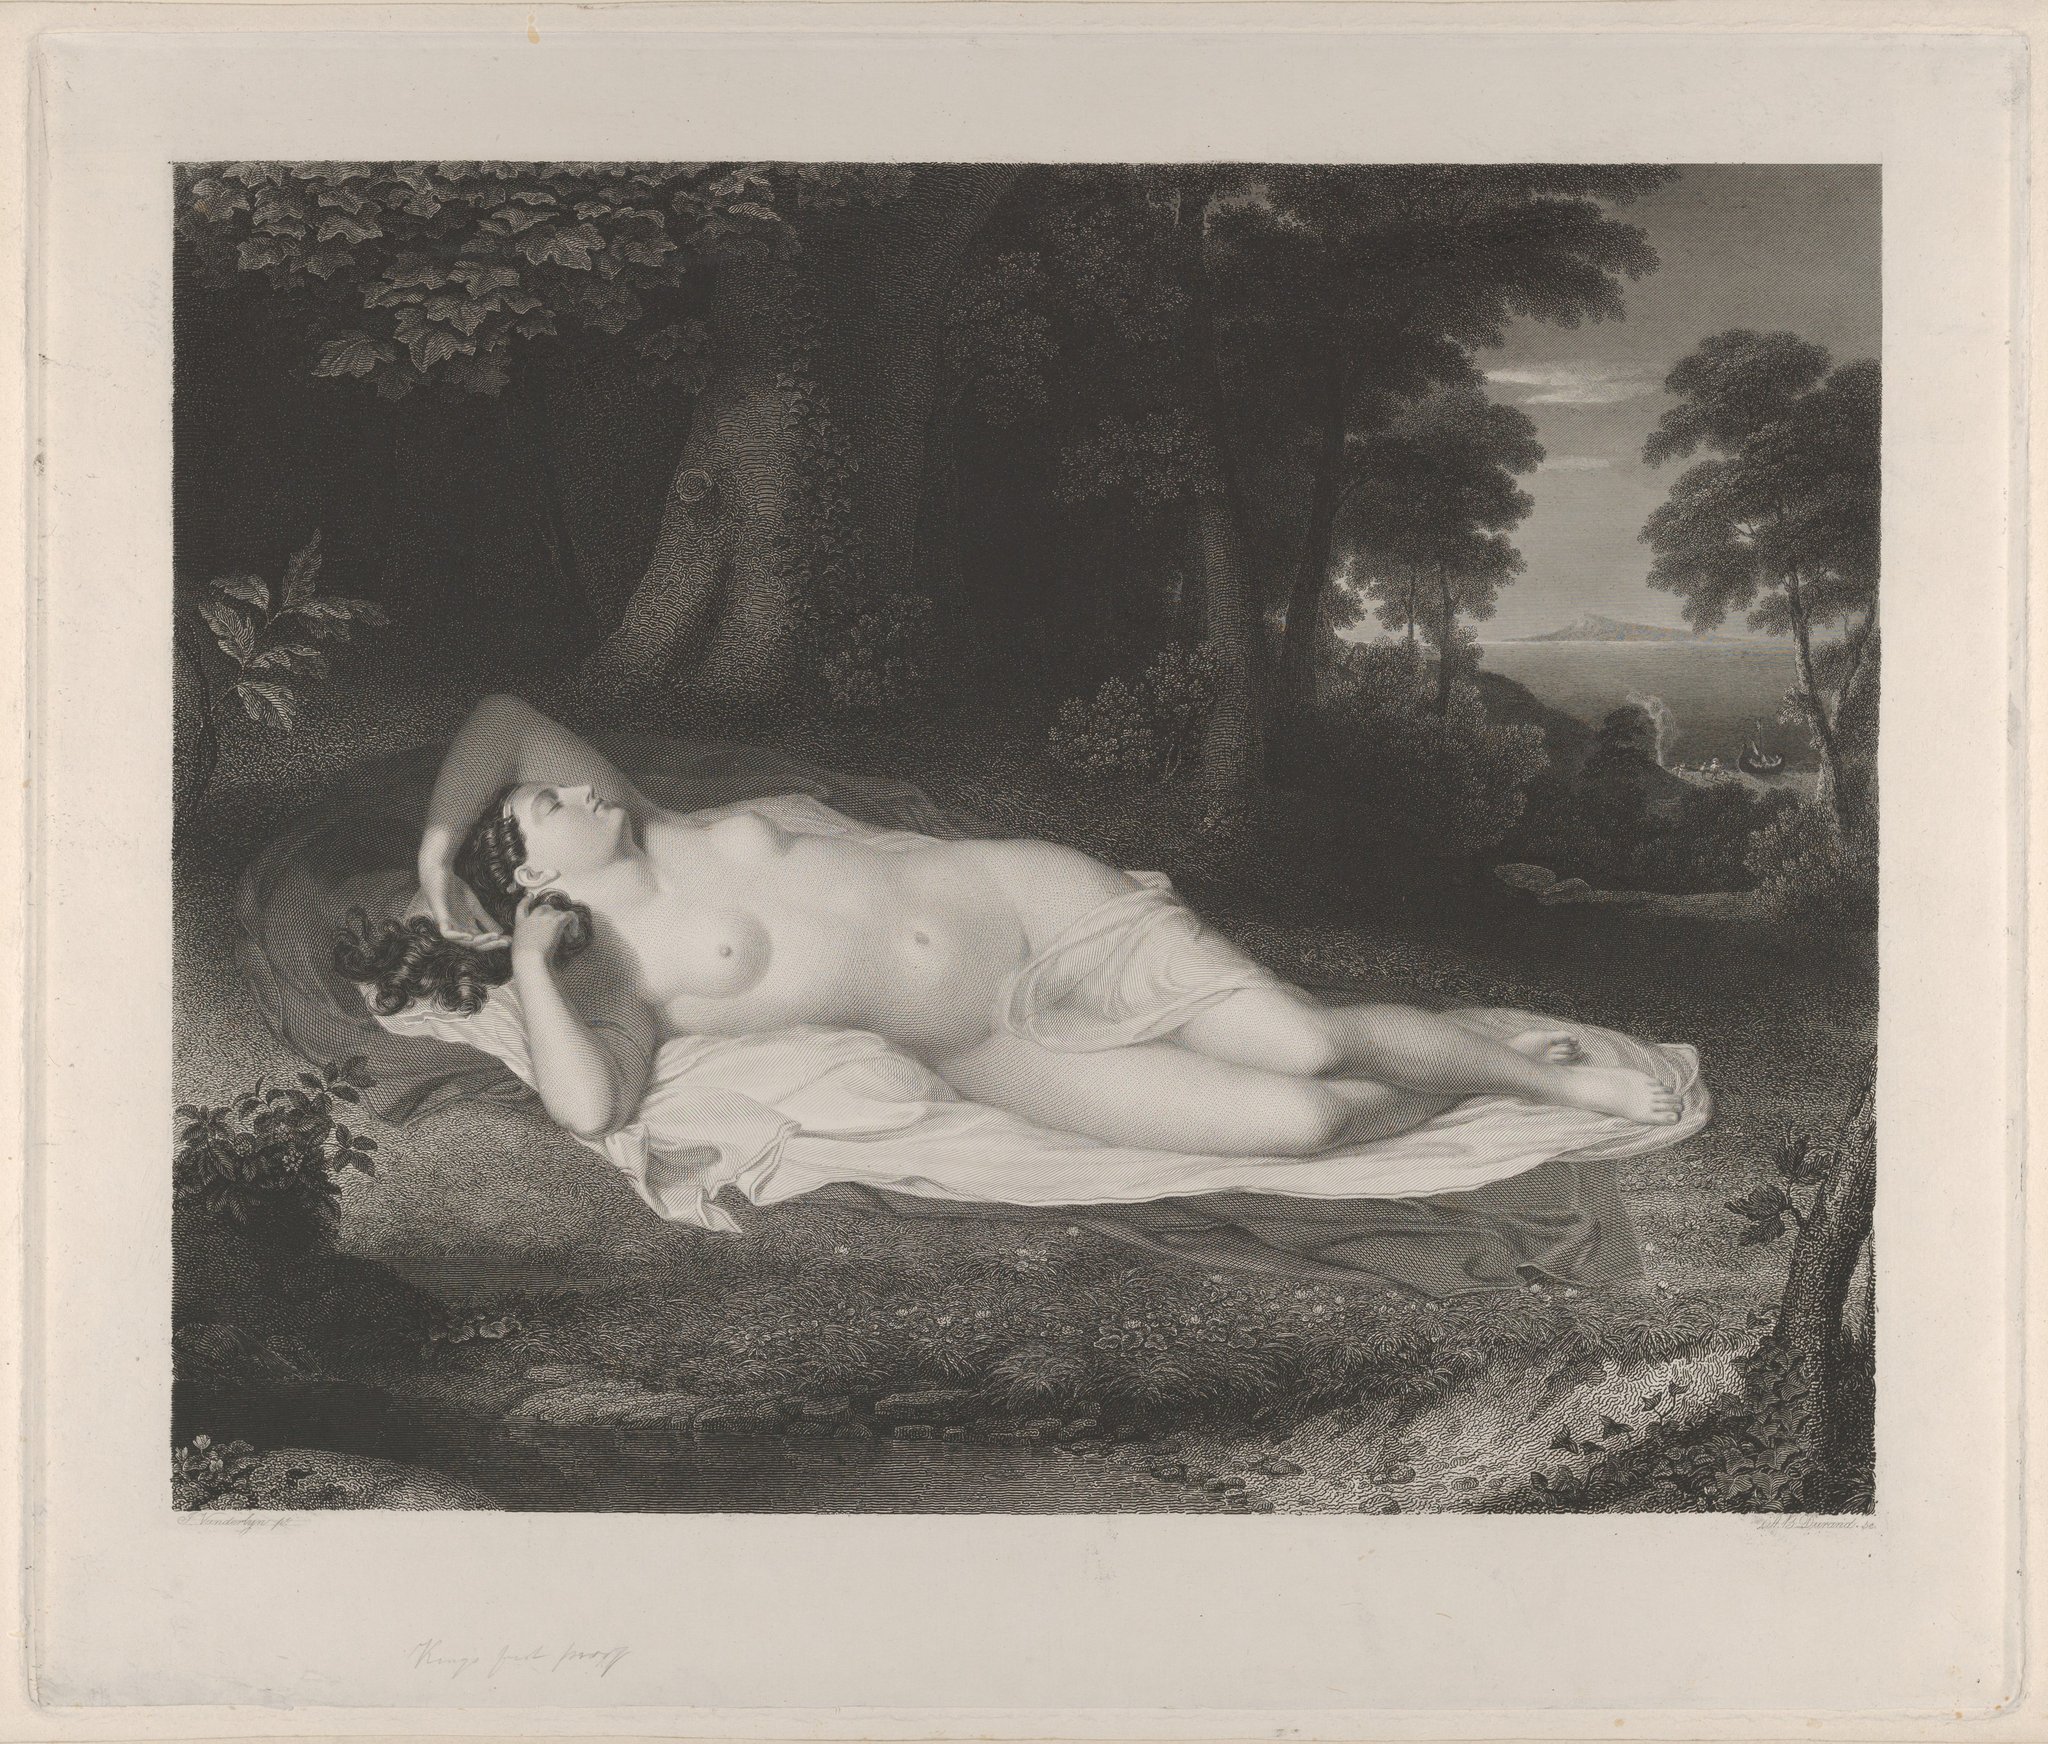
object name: print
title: Ariadne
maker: asher brown durand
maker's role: artist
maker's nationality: american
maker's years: 1796-1886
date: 1834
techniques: engraving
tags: ariadne